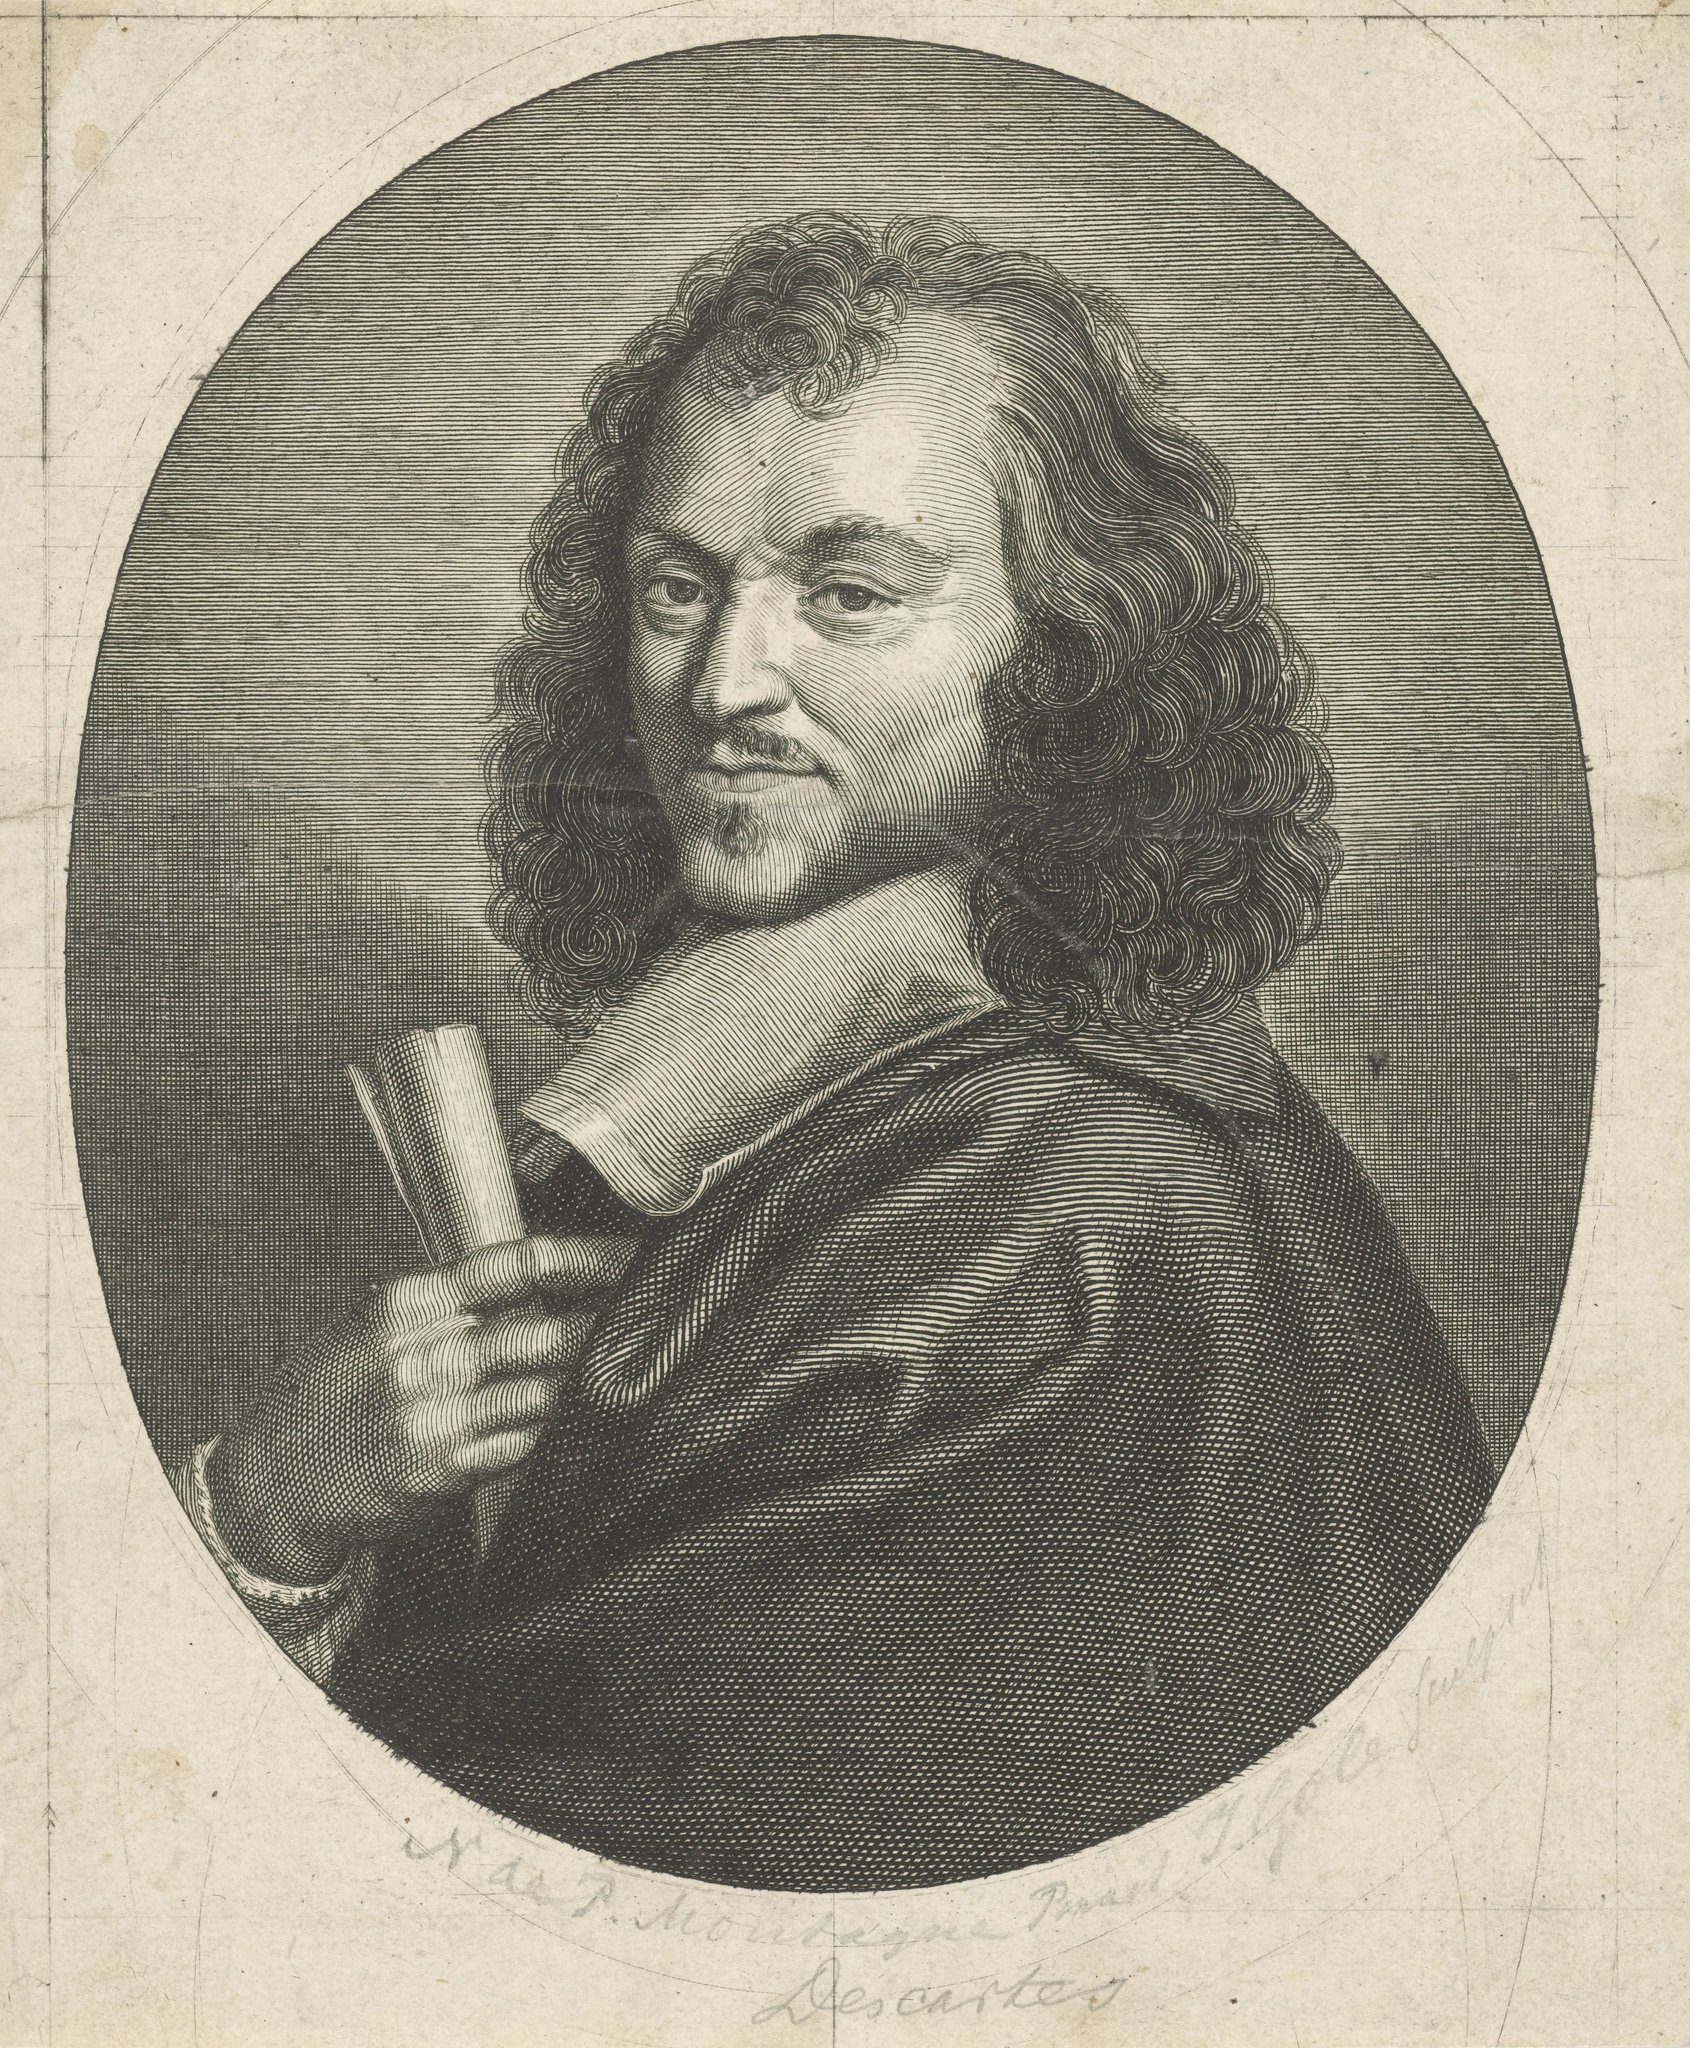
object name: print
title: Portret van René Descartes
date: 1670-1724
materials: paper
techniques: engraving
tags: rené descartes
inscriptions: collector's mark: Lugt 2228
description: Portret in ovale lijst van René Descartes, Franse filosoof en wiskundige. Ten halven lijve naar links.